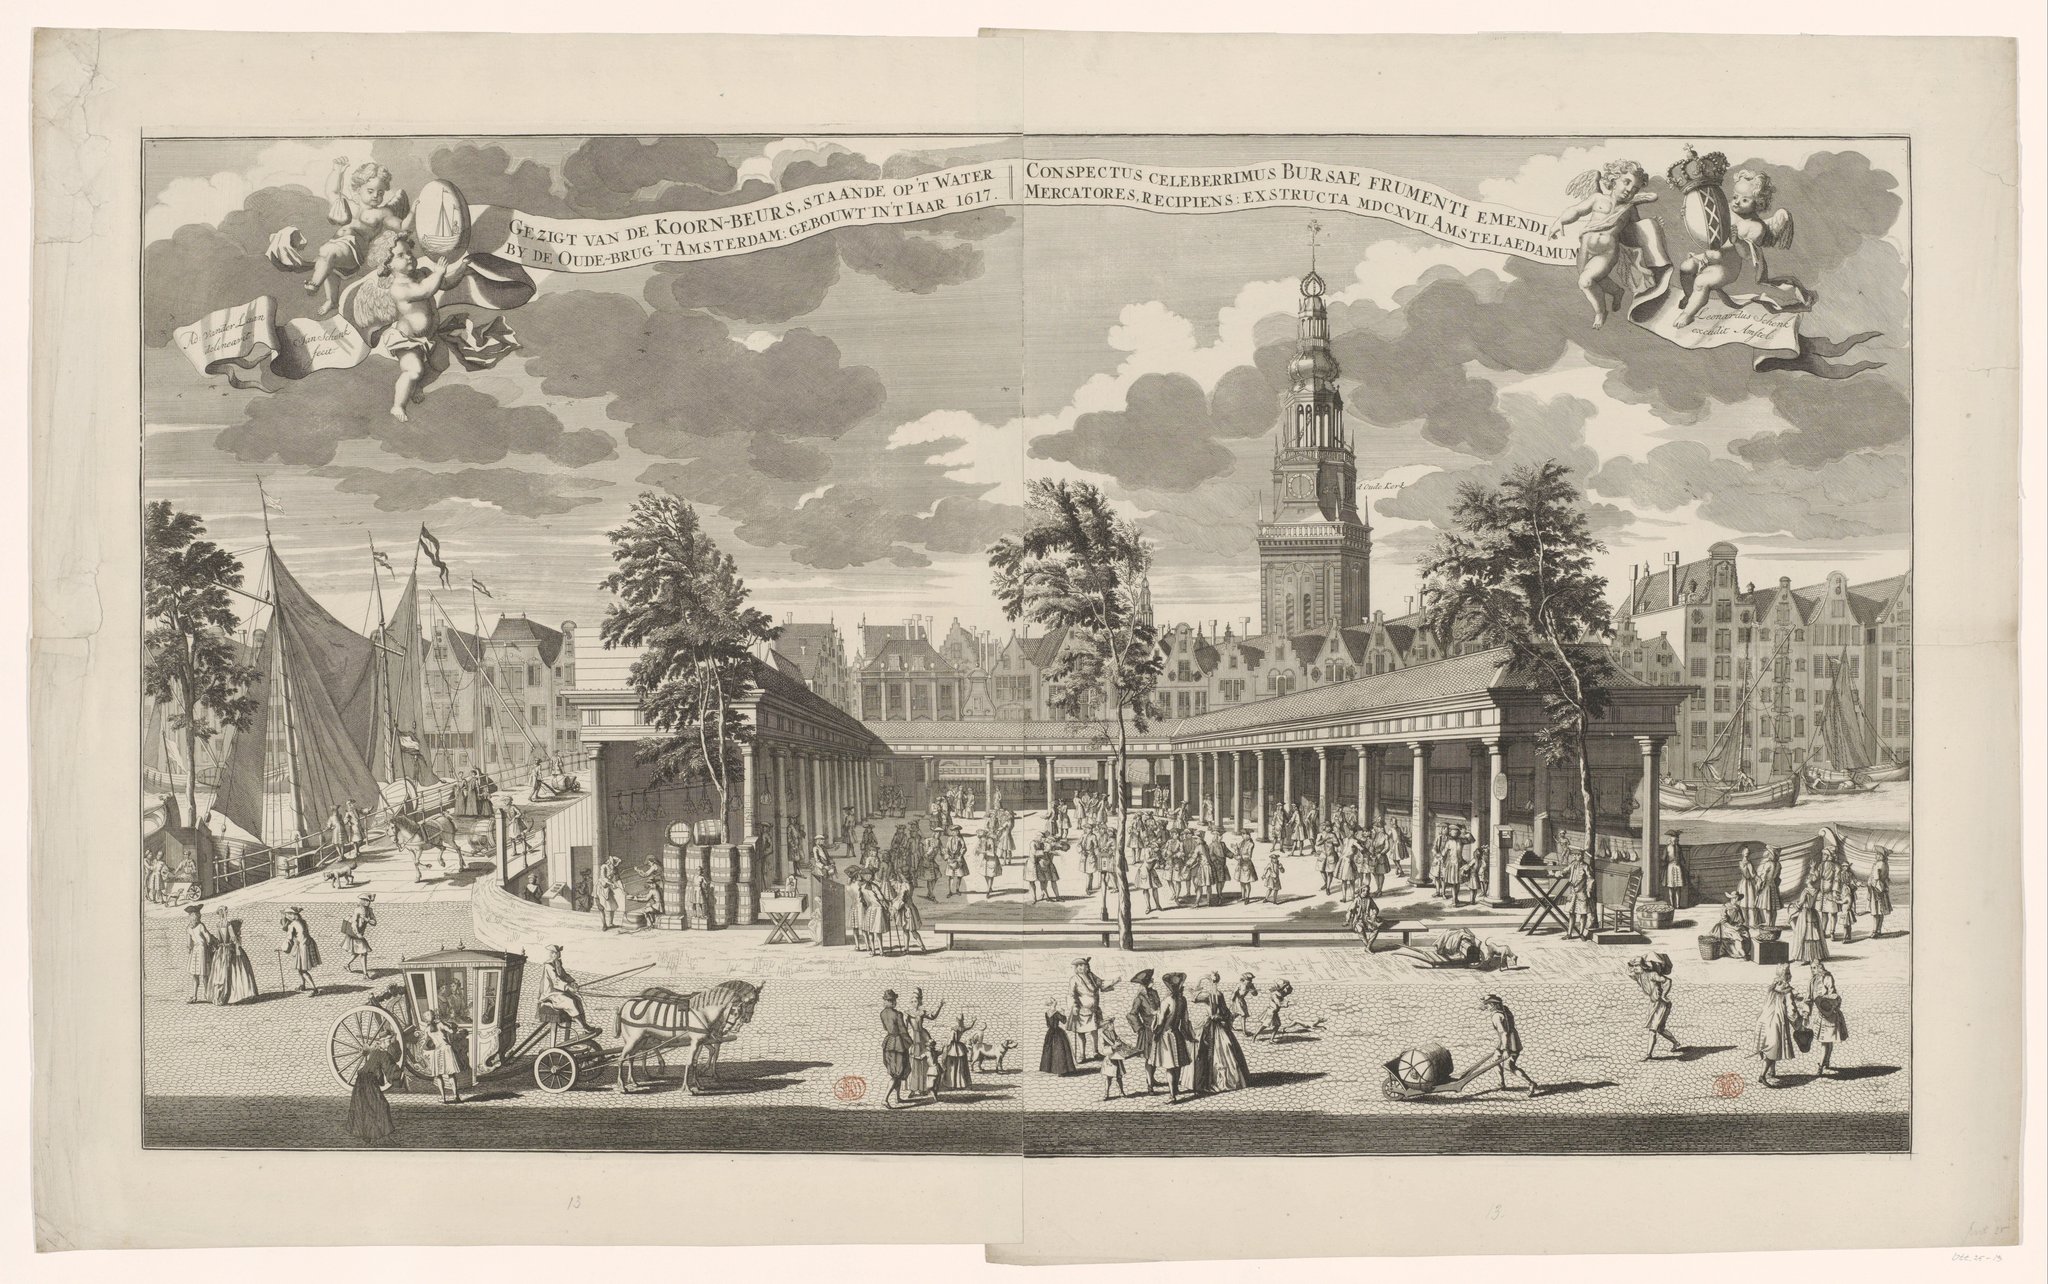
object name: print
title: Gezicht op de Korenbeurs te Amsterdam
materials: paper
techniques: etching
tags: korenbeurs